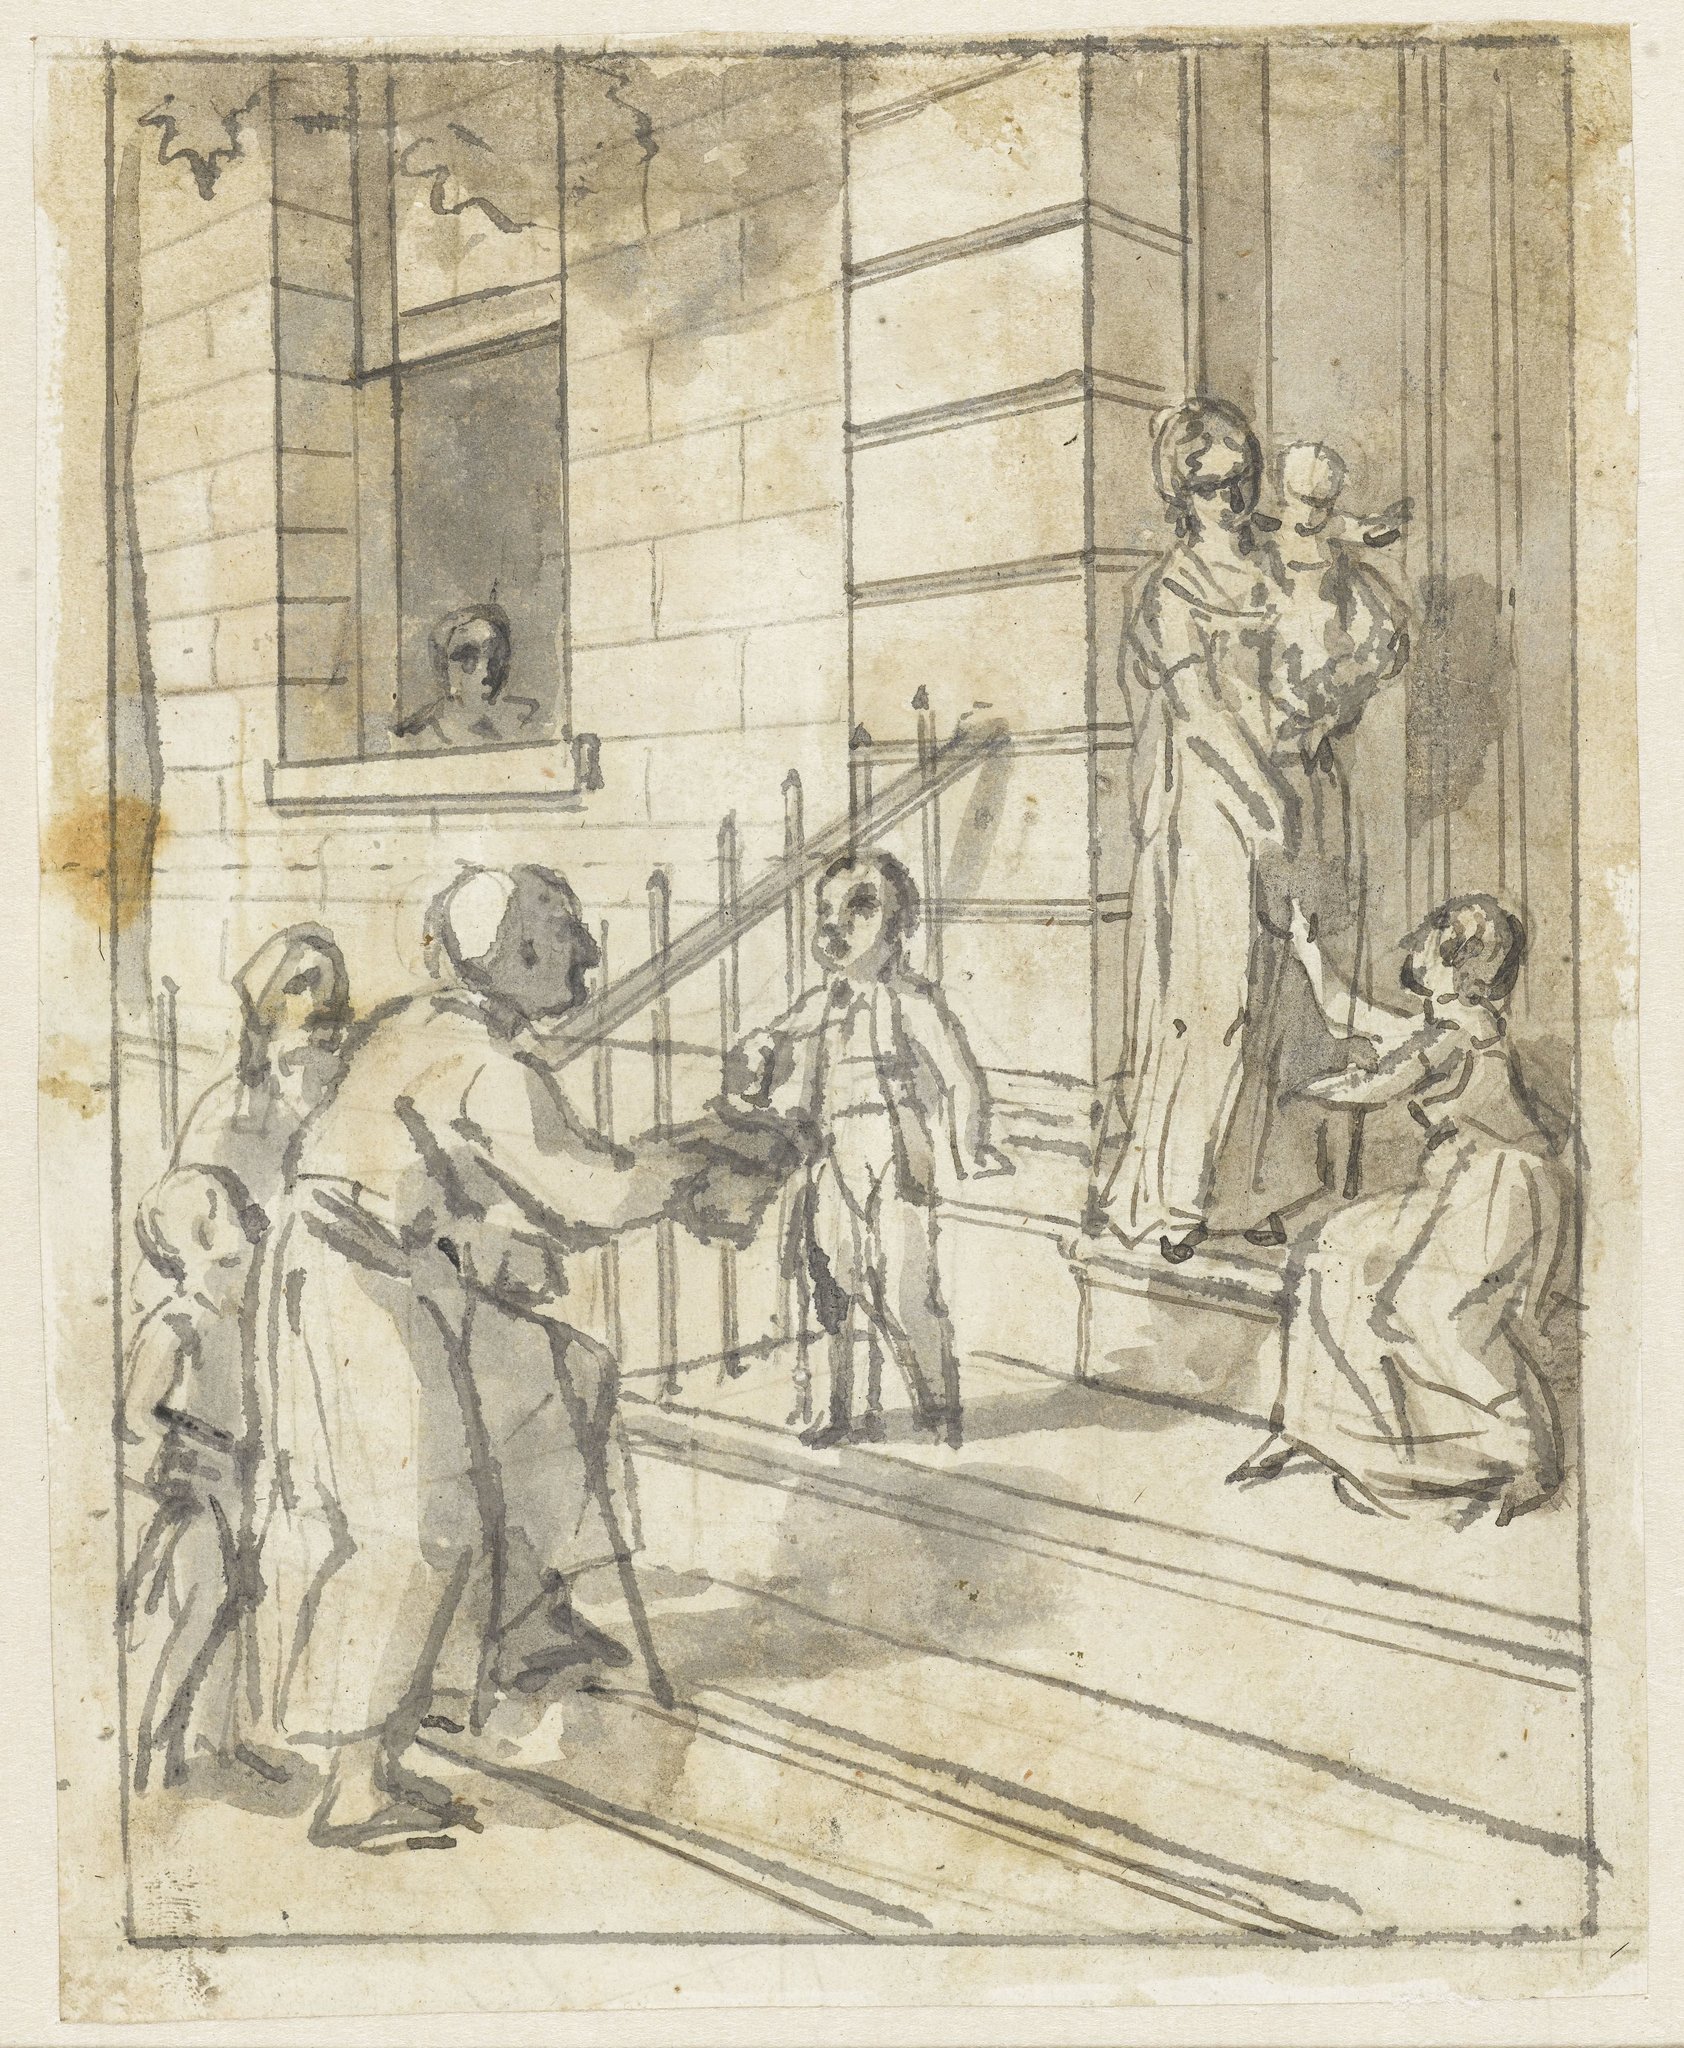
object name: drawing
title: Scène voor een huis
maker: jurriaan andriessen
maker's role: draughtsman, painter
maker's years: 1742-1819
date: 1752-1819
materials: graphite, ink, paper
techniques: brush, pen